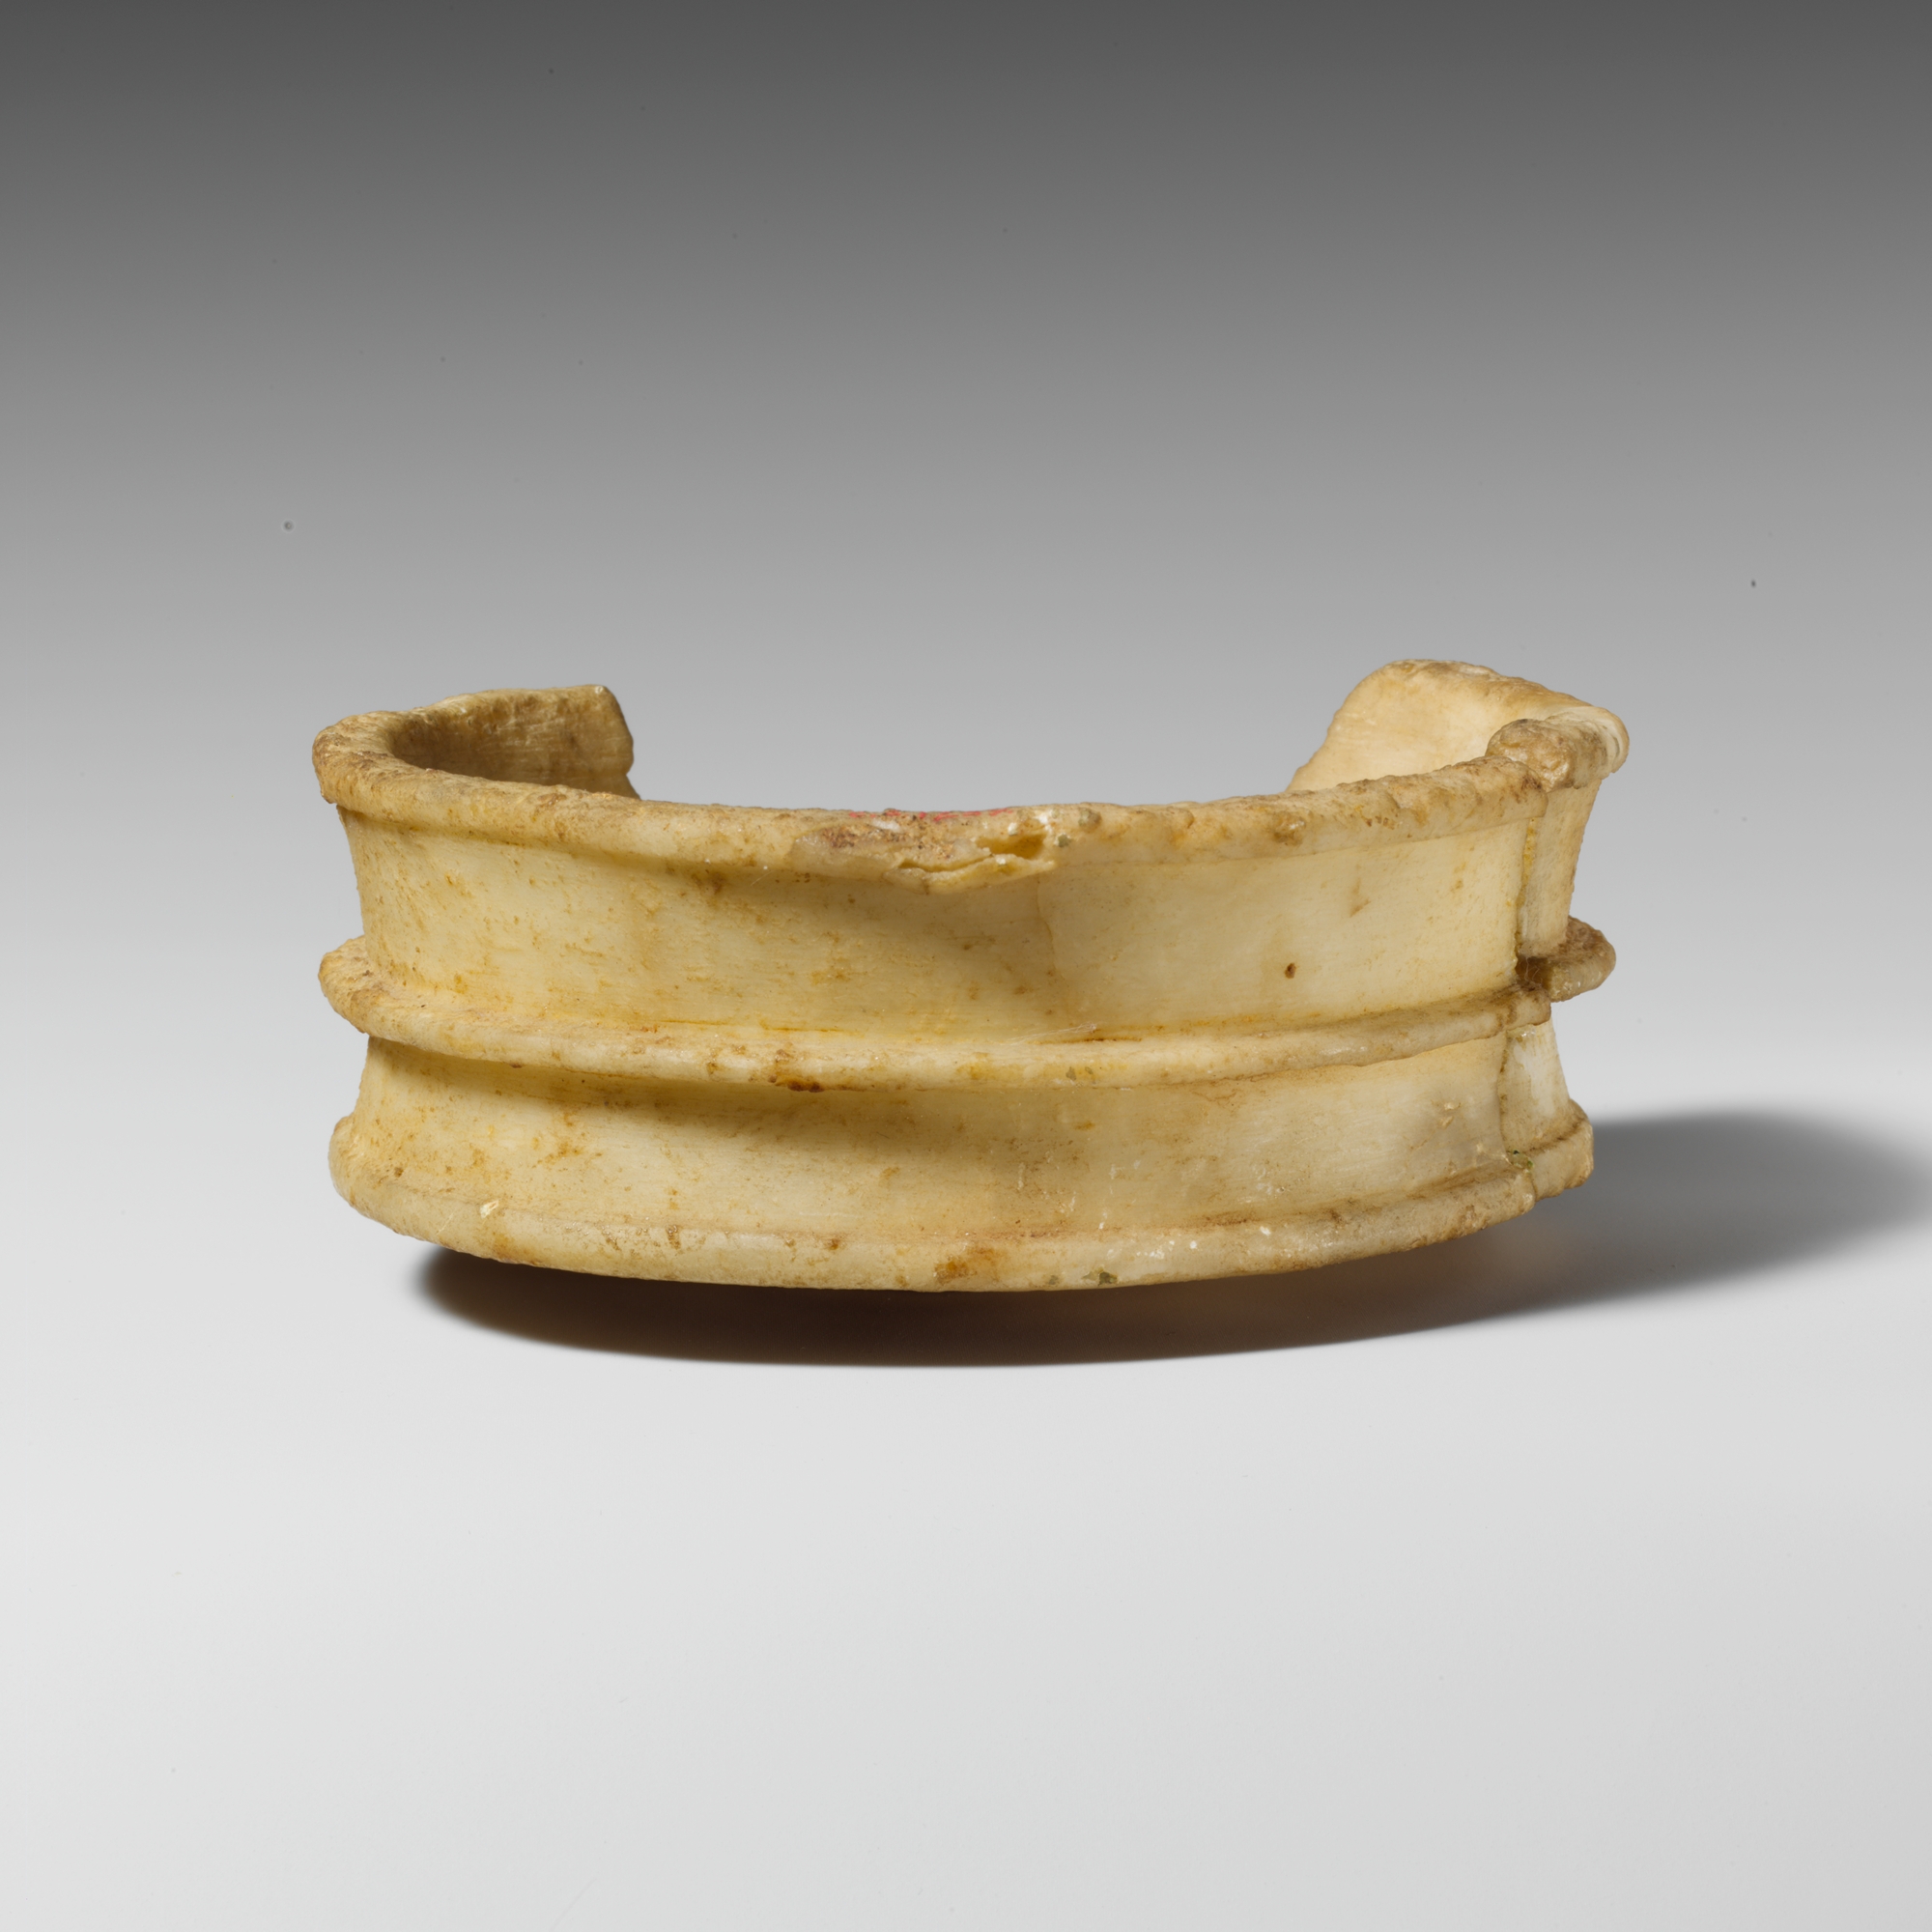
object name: bowl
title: Fragmentary alabaster stemmed bowl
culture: cypriot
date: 1600-1200 BCE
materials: gypsum